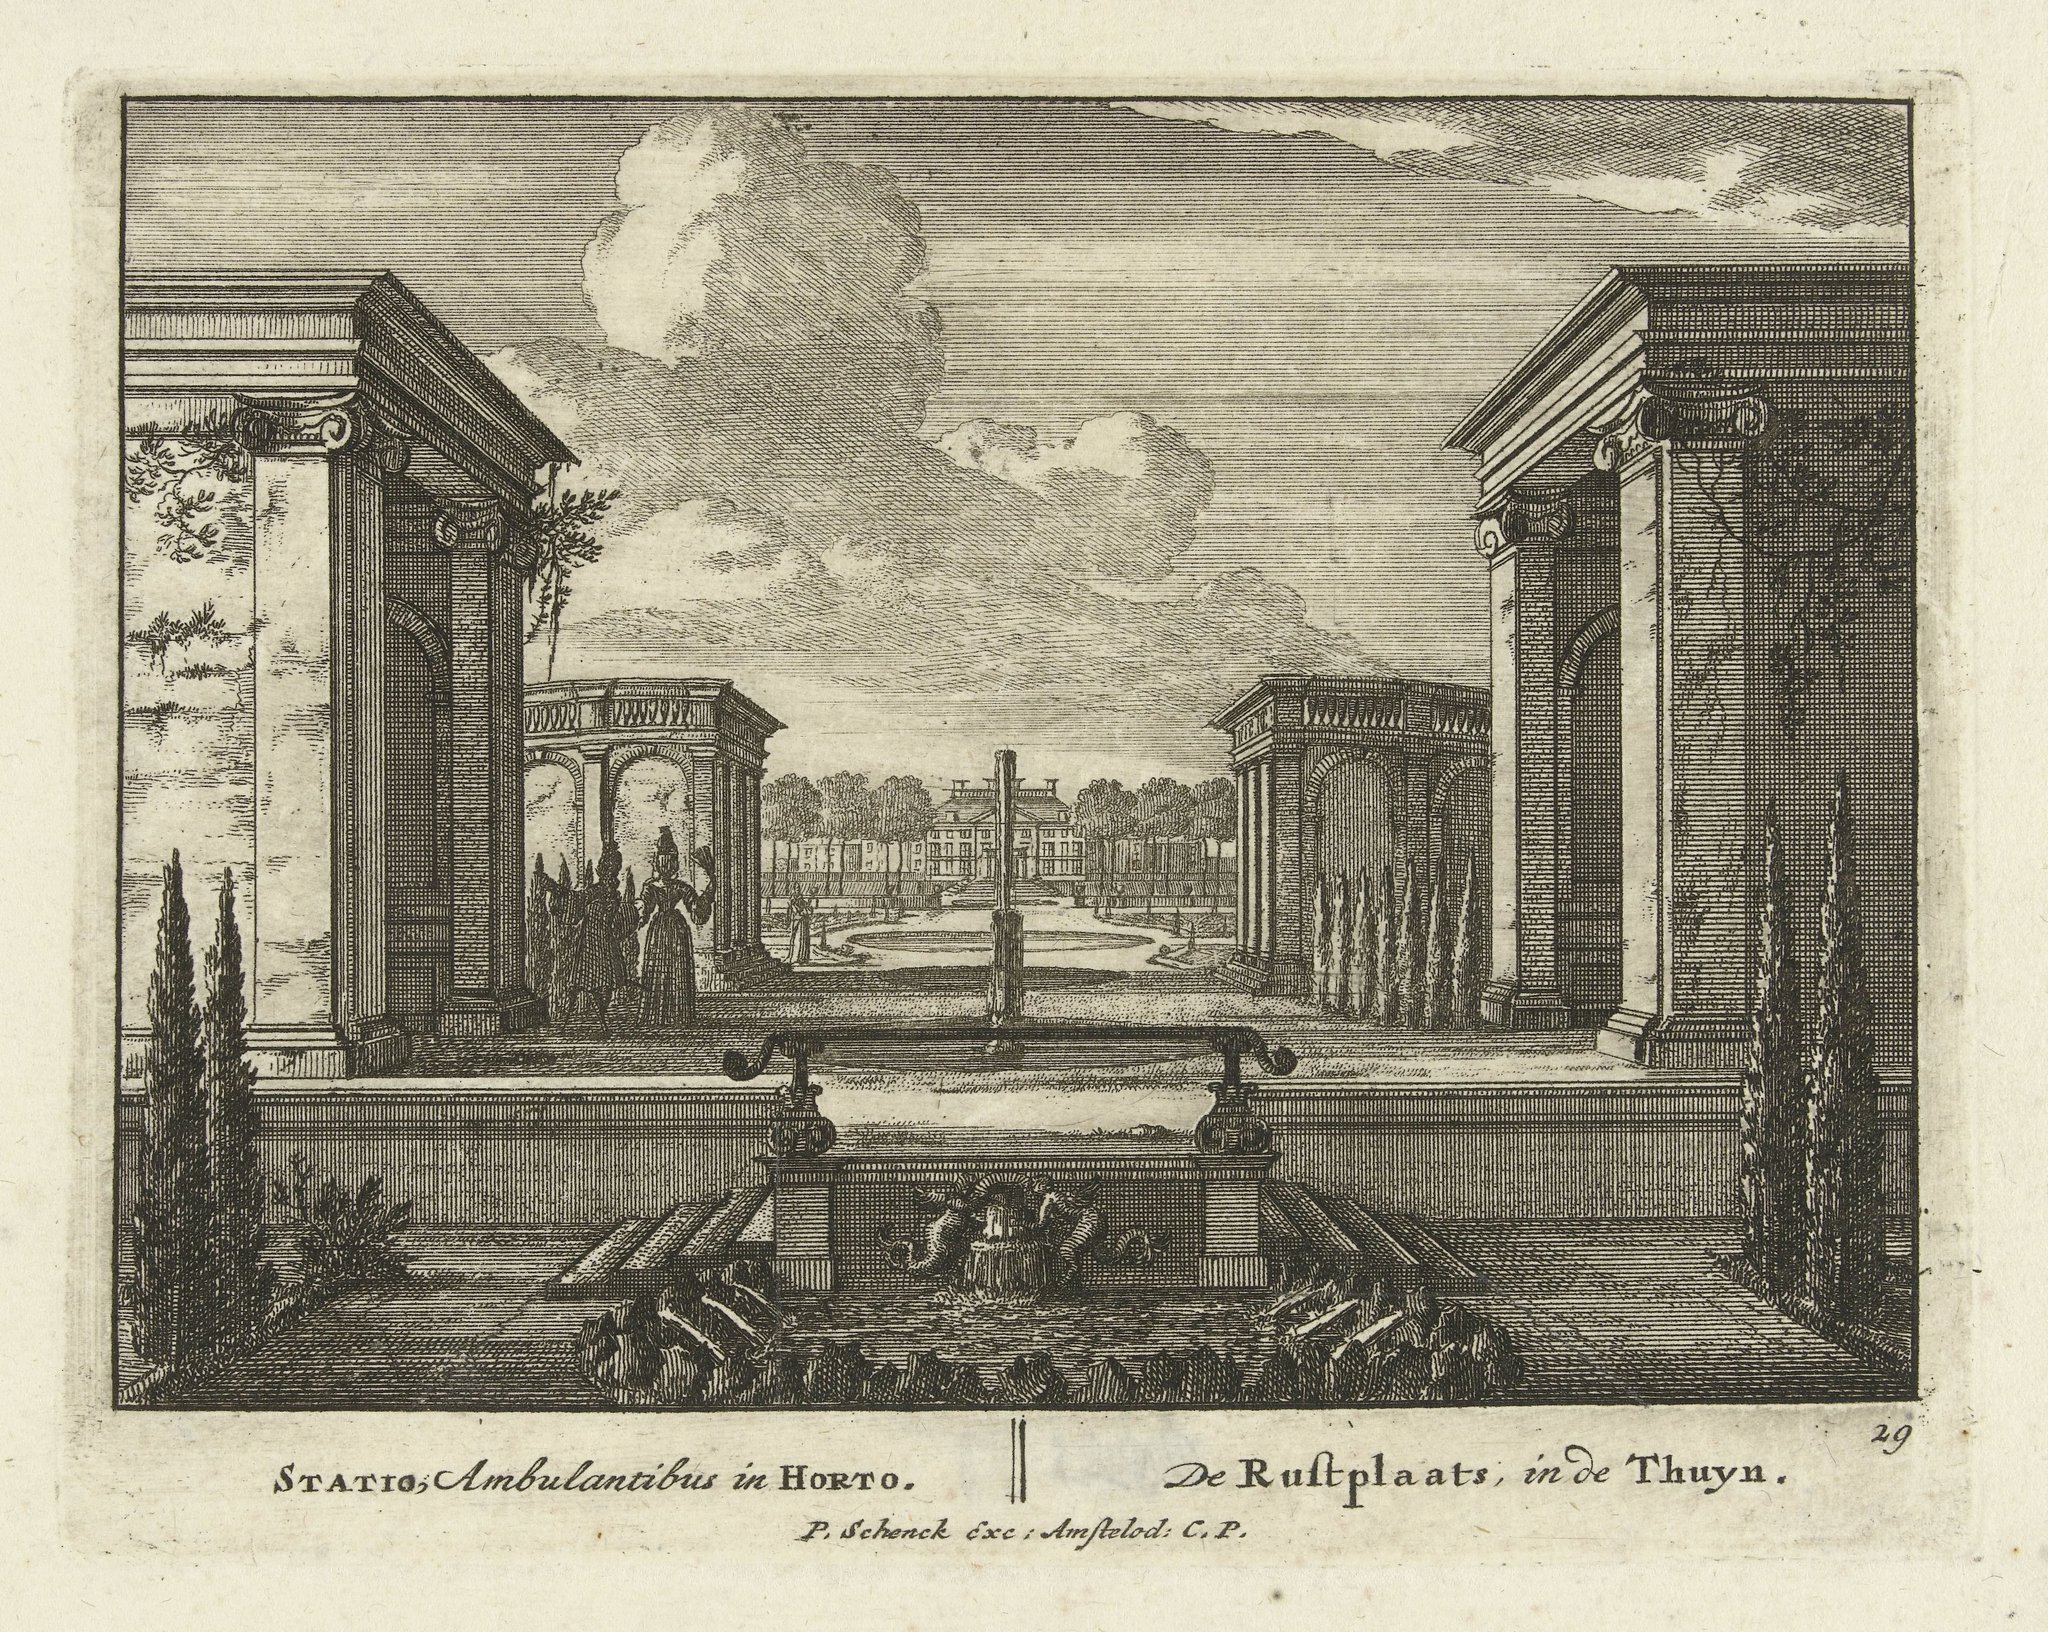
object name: print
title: Paviljoens in de tuinen van Paleis Het Loo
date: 1695-1705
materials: paper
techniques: etching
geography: amsterdam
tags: palace, french or architectonic garden; formal garden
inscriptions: collector's mark: Lugt 2228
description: Gezicht op een waterbassin en de vier paviljoens aan weerszijden van de middenas van de tuinen van Het Loo. Langs de zichtas is op de achtergrond het paleis te zien. Prent uit een serie van 71 prenten met Rijnlandschappen, gezichten op vorstelijke paleizen en stadsgezichten uit Den Haag en Amsterdam.